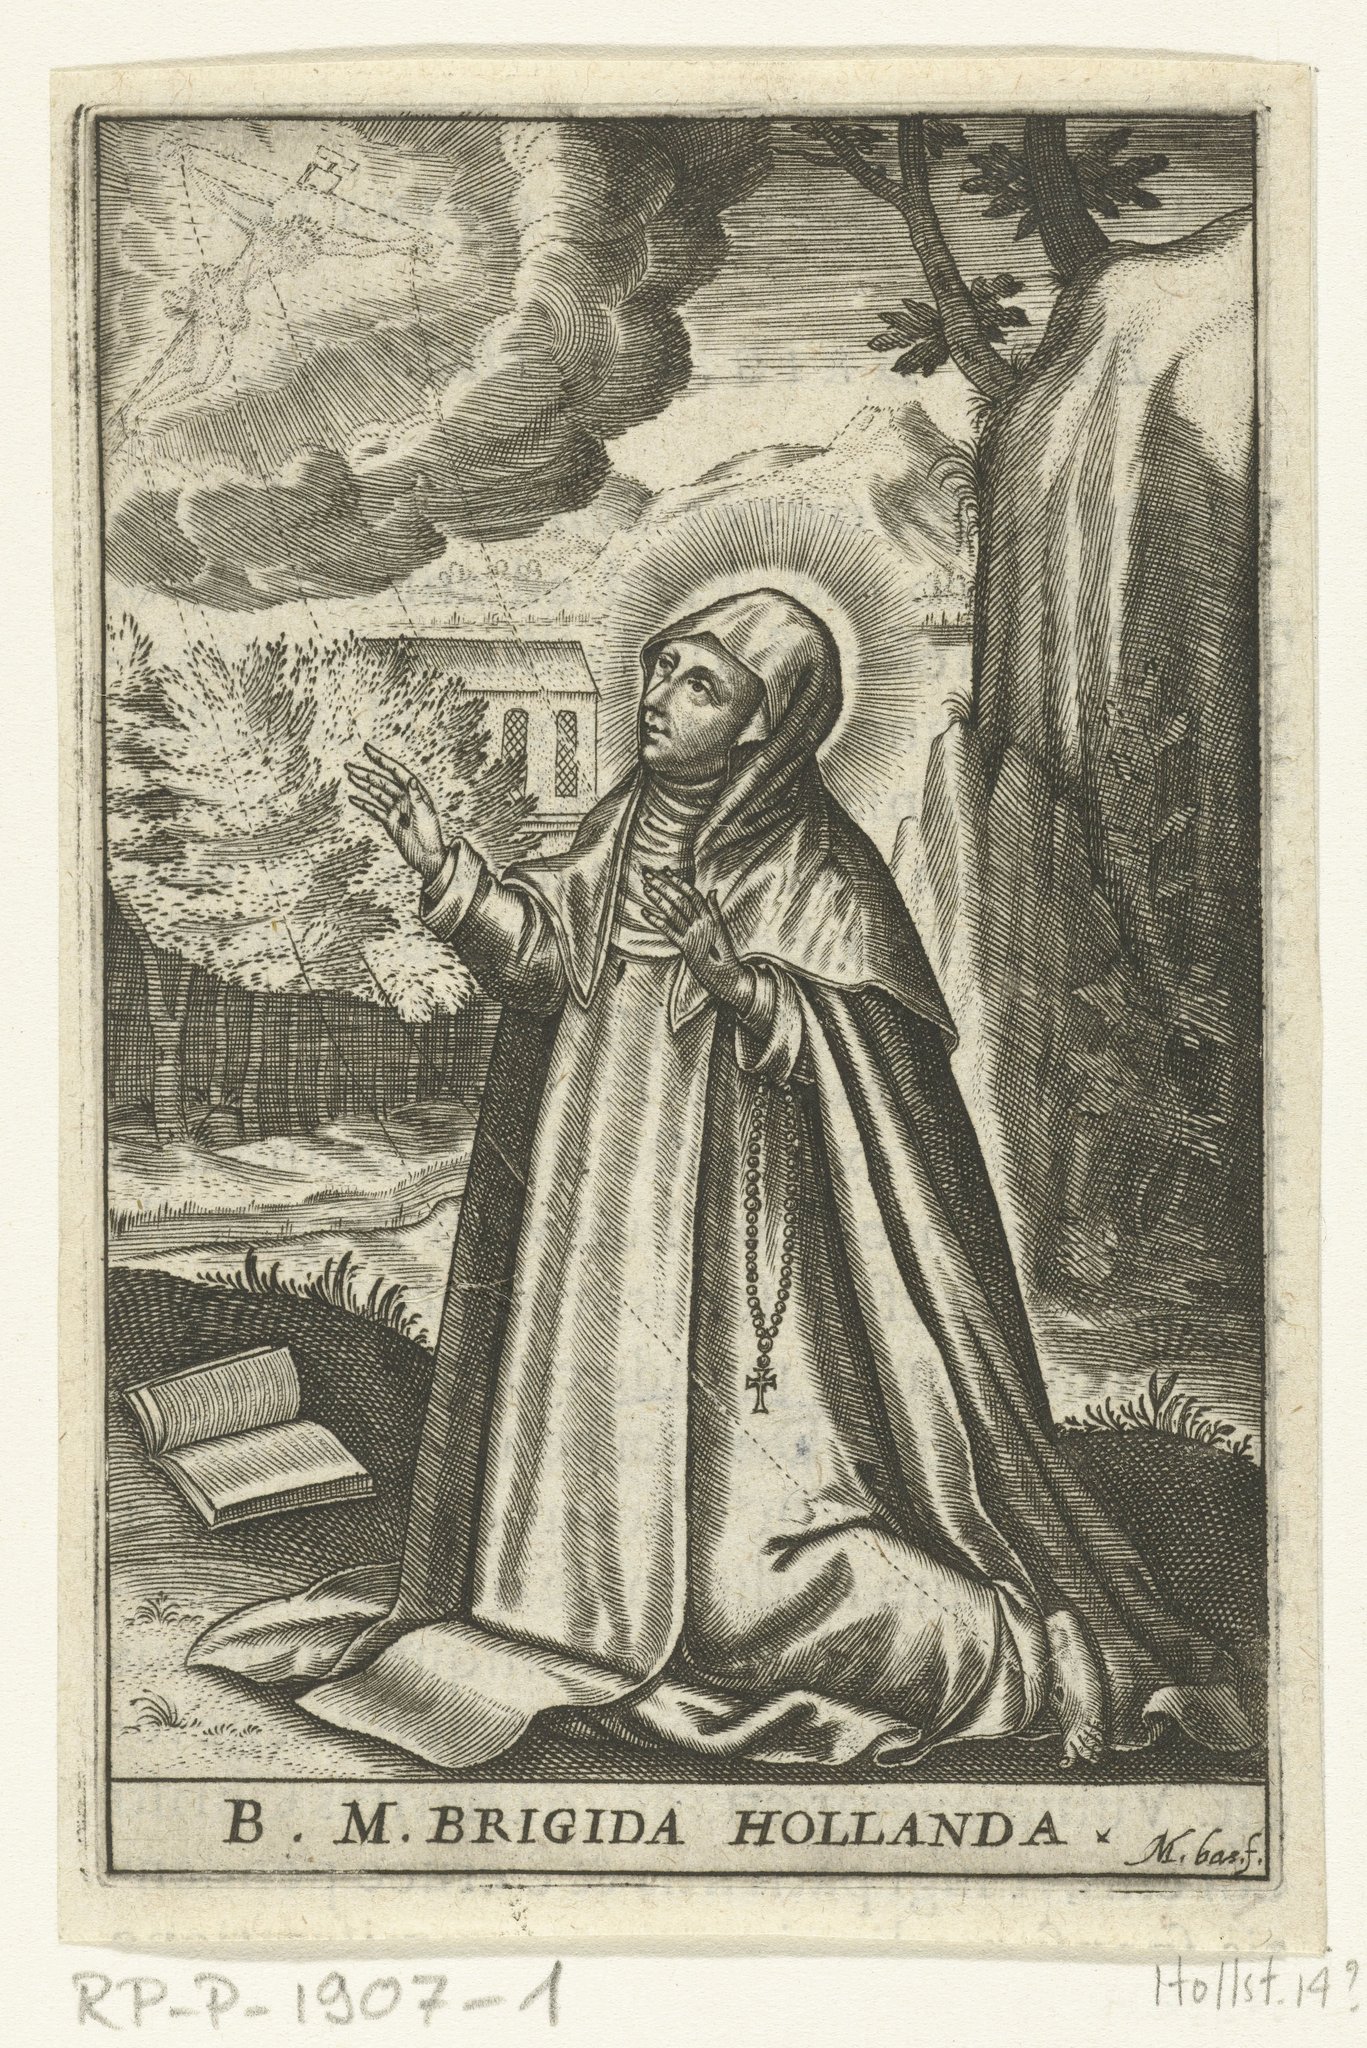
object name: print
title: De heilige Brigida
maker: martin baes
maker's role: print maker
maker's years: 1604-1637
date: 1618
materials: paper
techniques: engraving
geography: douai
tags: female saints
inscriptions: collector's mark: Lugt 2228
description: Bladzijde uit een boek met de heilige Brigida in Dominicaans habijt. De heilige heeft een visioen van een crucifix en de wonden van Christus worden aan haar overgedragen. Aan de versokant het begin van een hoofdstuk over de heilige Brigida in het Latijn.